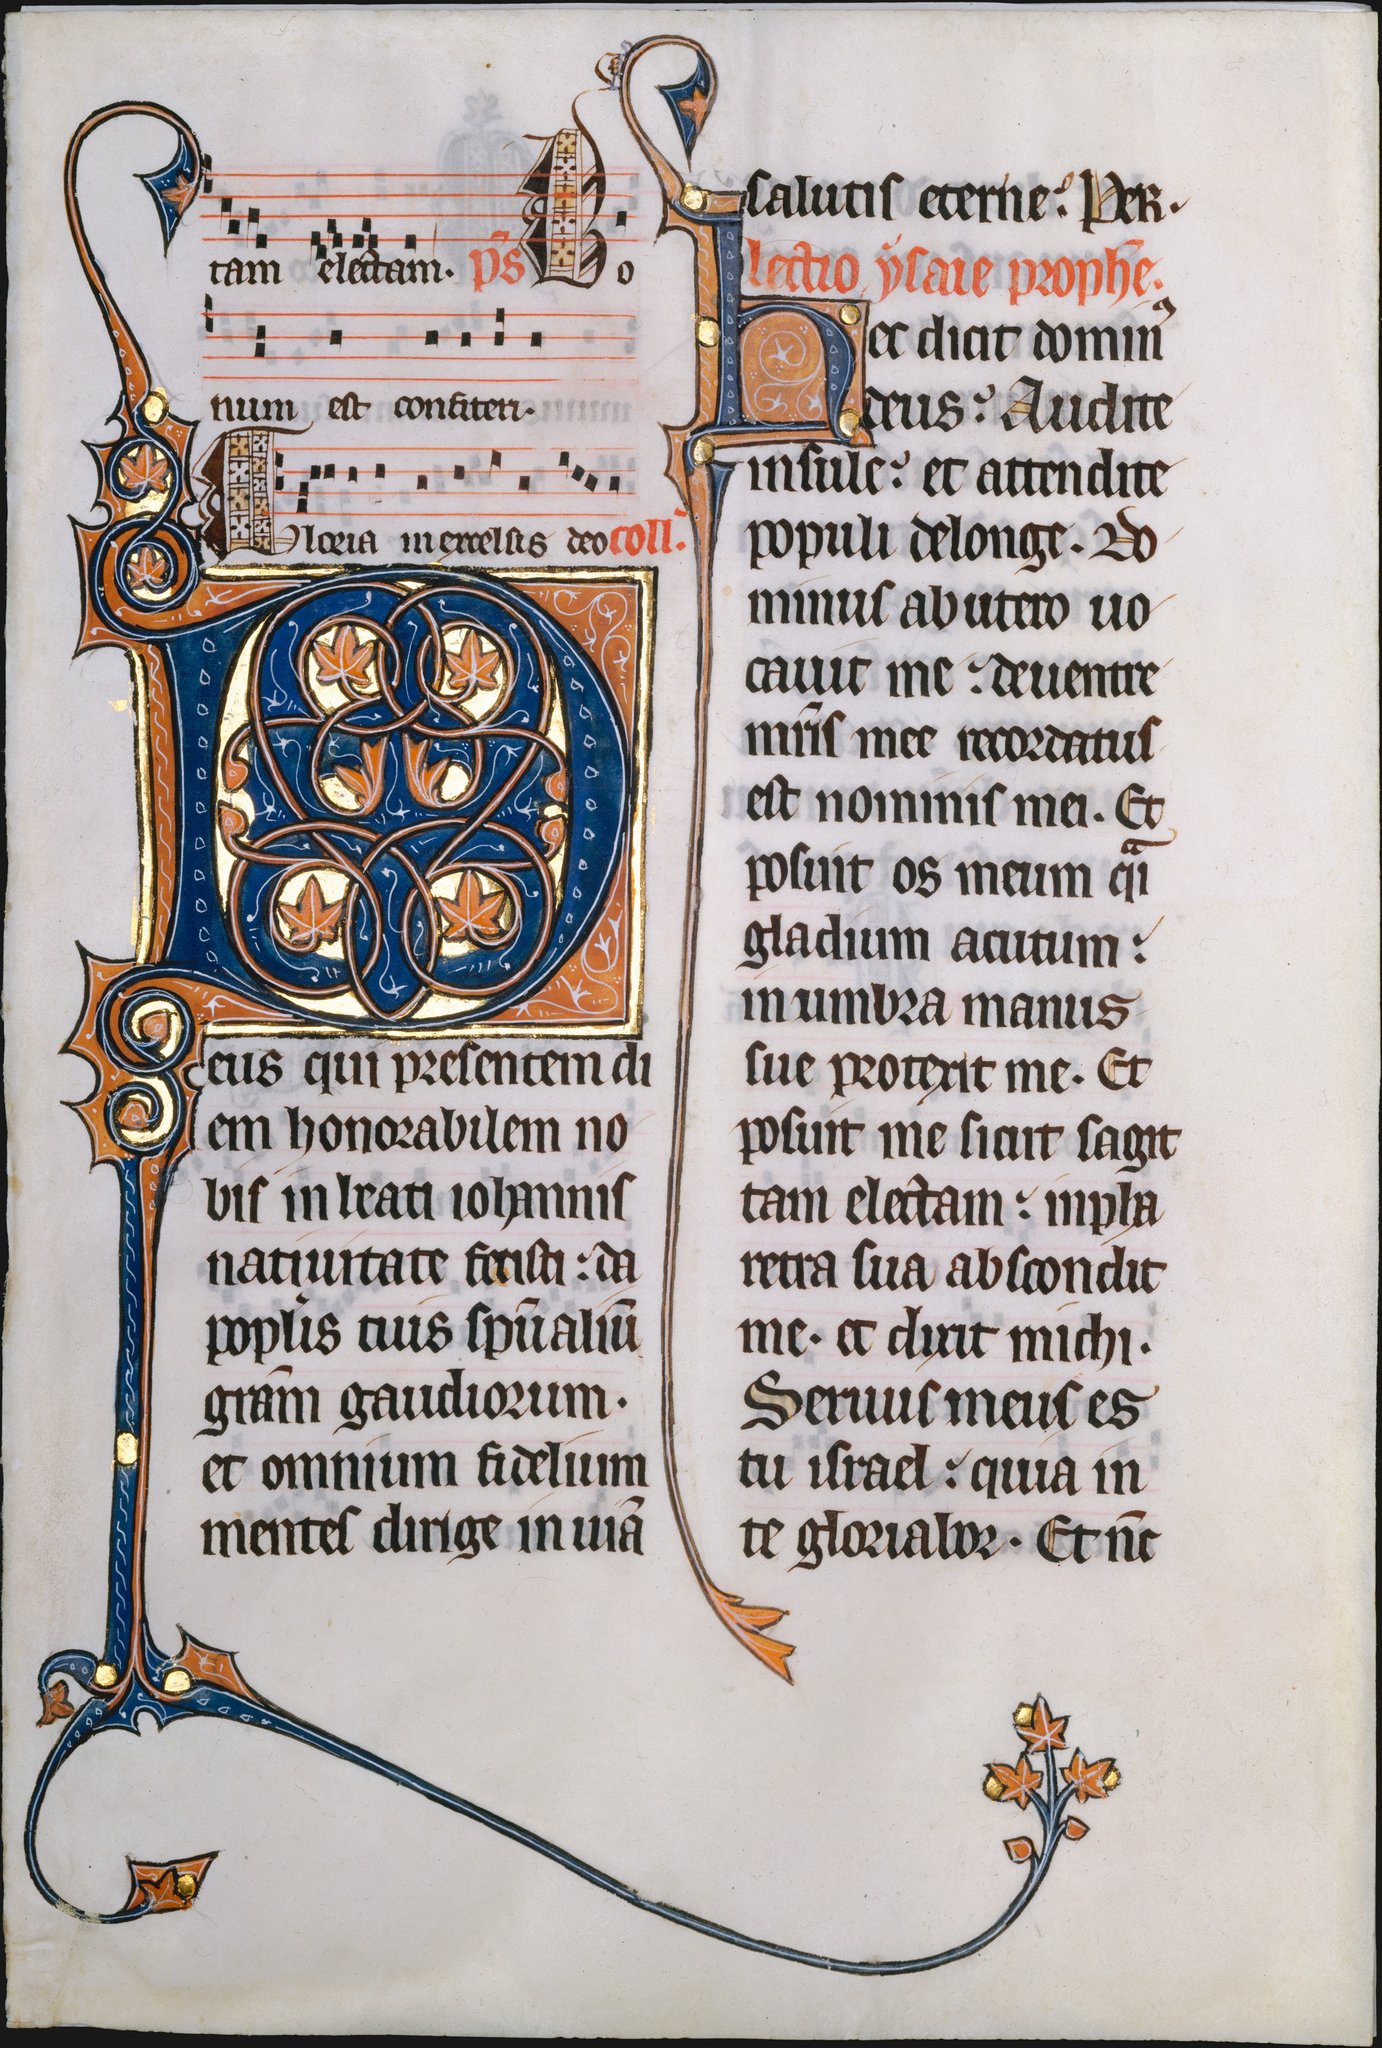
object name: missal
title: Manuscript Leaf with Initial M, from a Missal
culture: french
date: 1290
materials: gold, parchment, paint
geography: france